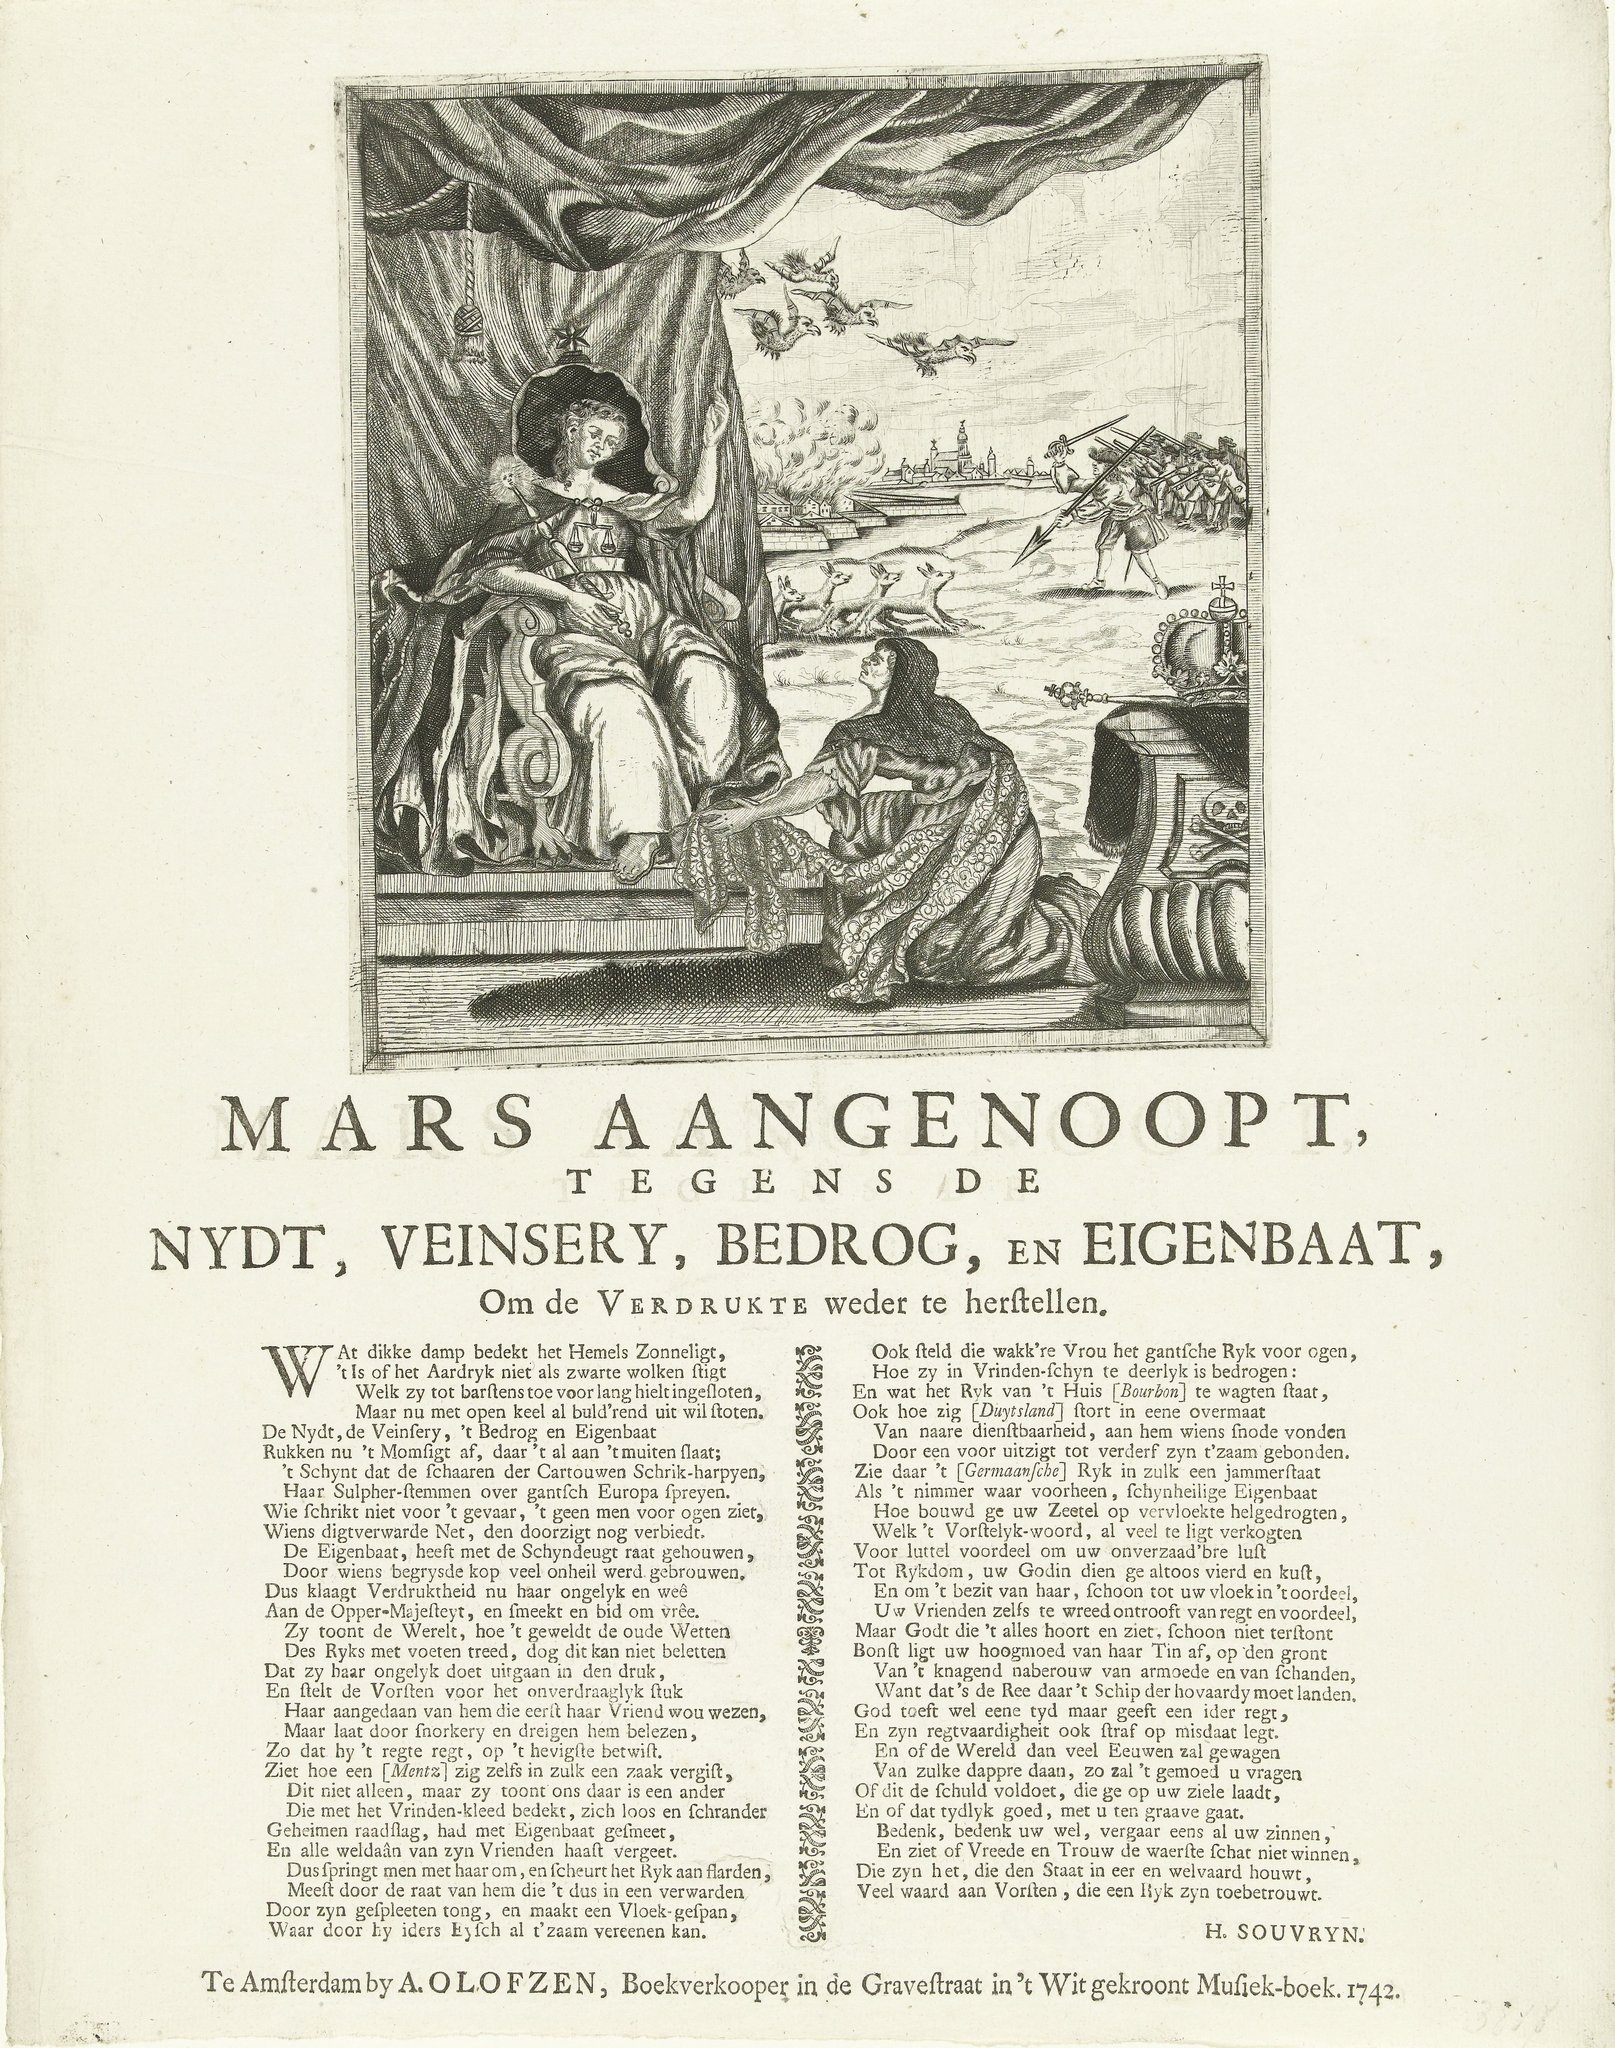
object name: print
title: Maria Theresia smeekt om hulp bij de Rechtvaardigheid, 1742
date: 1742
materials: paper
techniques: engraving, etching, letterpress printing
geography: amsterdam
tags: vienna, maria theresia (rooms-duits keizerin), justice, 'justitia'; 'giustitia divina' (ripa) ~ one of the four cardinal virtues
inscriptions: collector's mark: Lugt 2228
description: Allegorie op treurige toestand van Oostenrijk in de Oostenrijkse Successieoorlog met Maria Theresia die knielend smeekt om hulp bij de Goddelijke Rechtvaardigheid, 1742. Rechts een graf met de keizerskroon en scepter. Op de achtergrond trekt een leger op tegen legers van wolven en roofvogels. Op het blad onder de plaat een vers in twee kolommen.